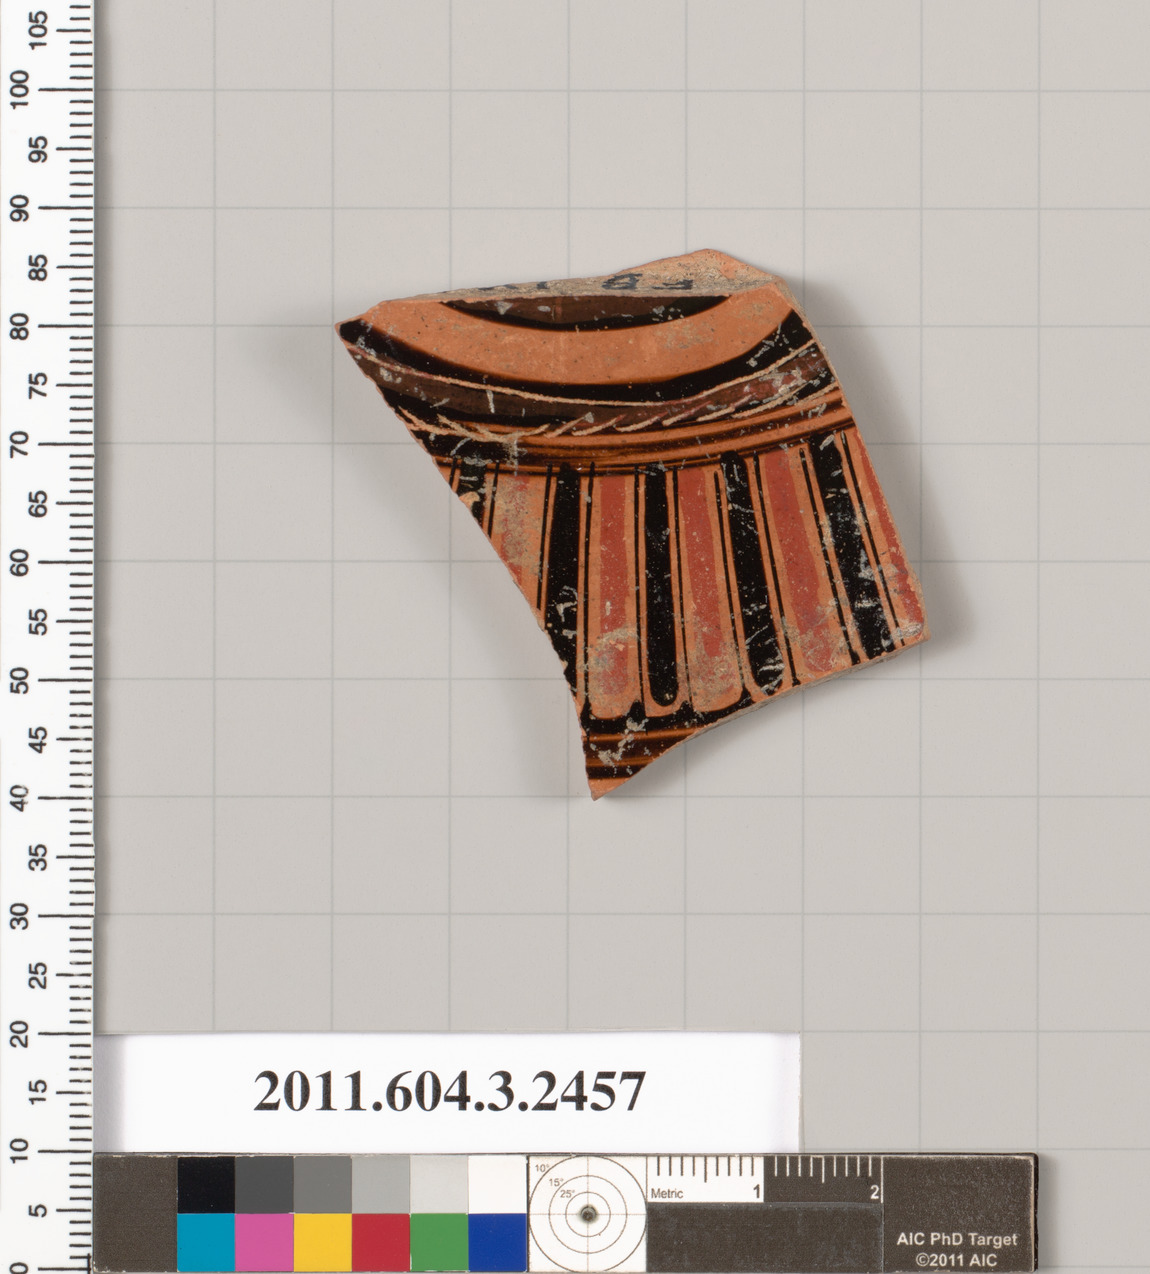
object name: kylix fragment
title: Terracotta fragment of a kylix (drinking cup)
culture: greek, attic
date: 530-510 BCE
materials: terracotta